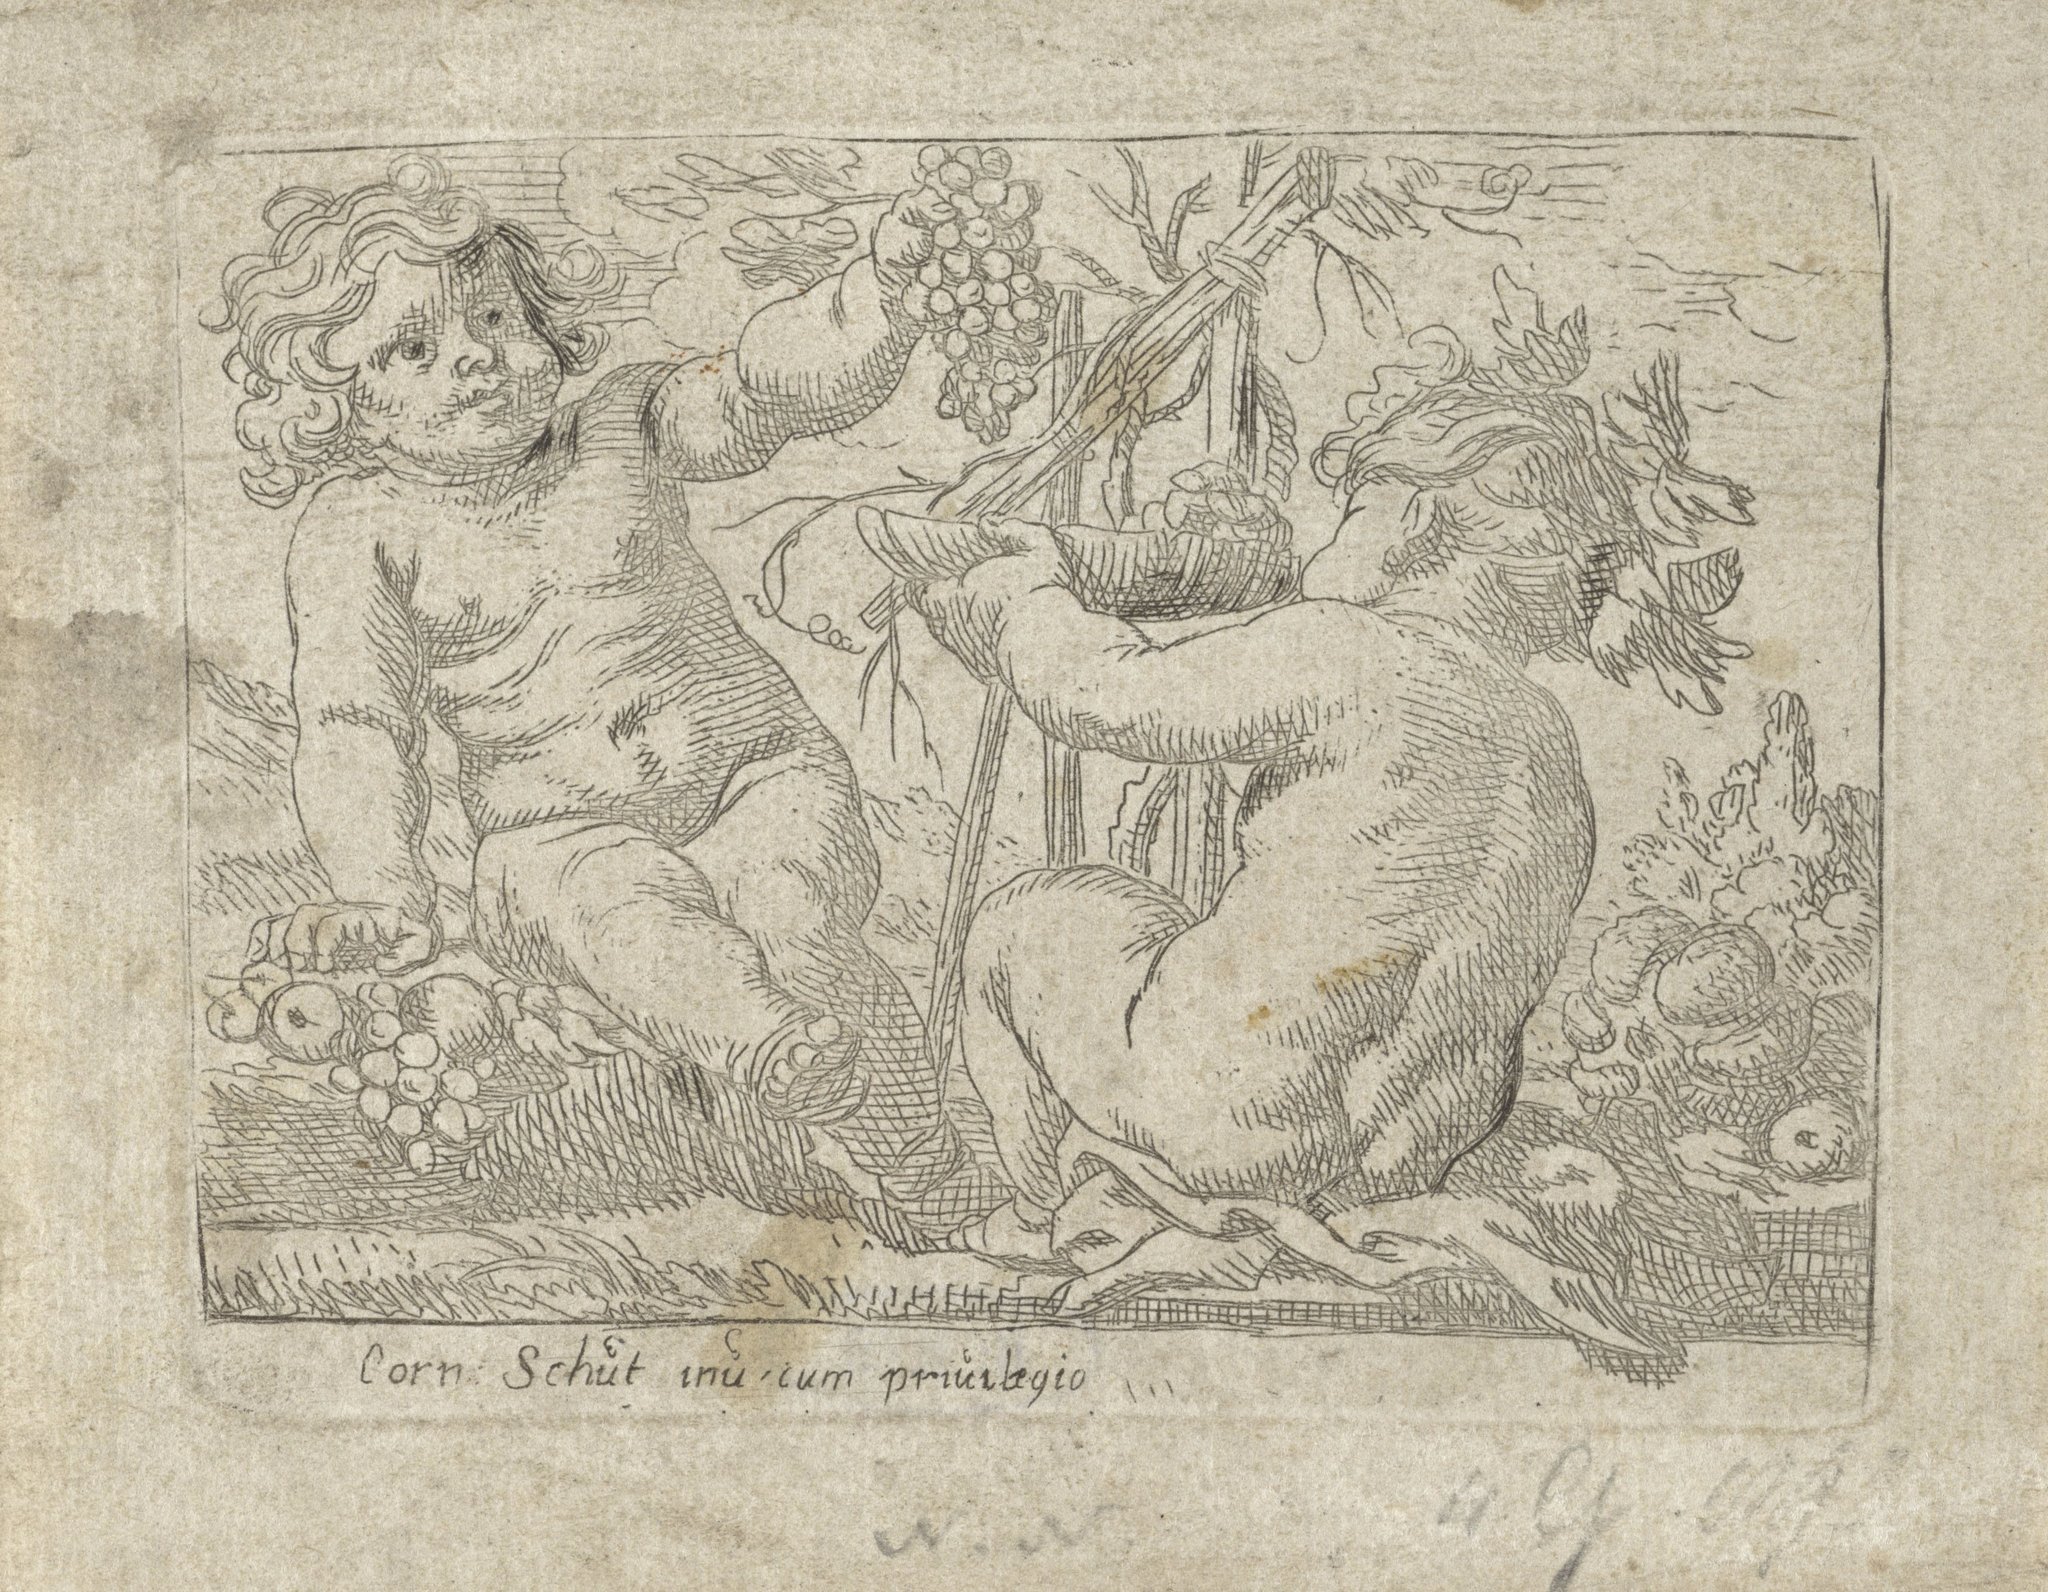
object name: print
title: Twee kinderen met een druiventros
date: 1618-1655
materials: paper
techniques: etching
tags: vintage, grape harvest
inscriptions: collector's mark: Lugt 2228, collector's mark: Lugt 2610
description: Een kind houdt een druiventros omhoog. Een ander kind reikt hem een schaal aan. Op de grond liggen stapels fruit. Op de achtergrond druivenstokken.